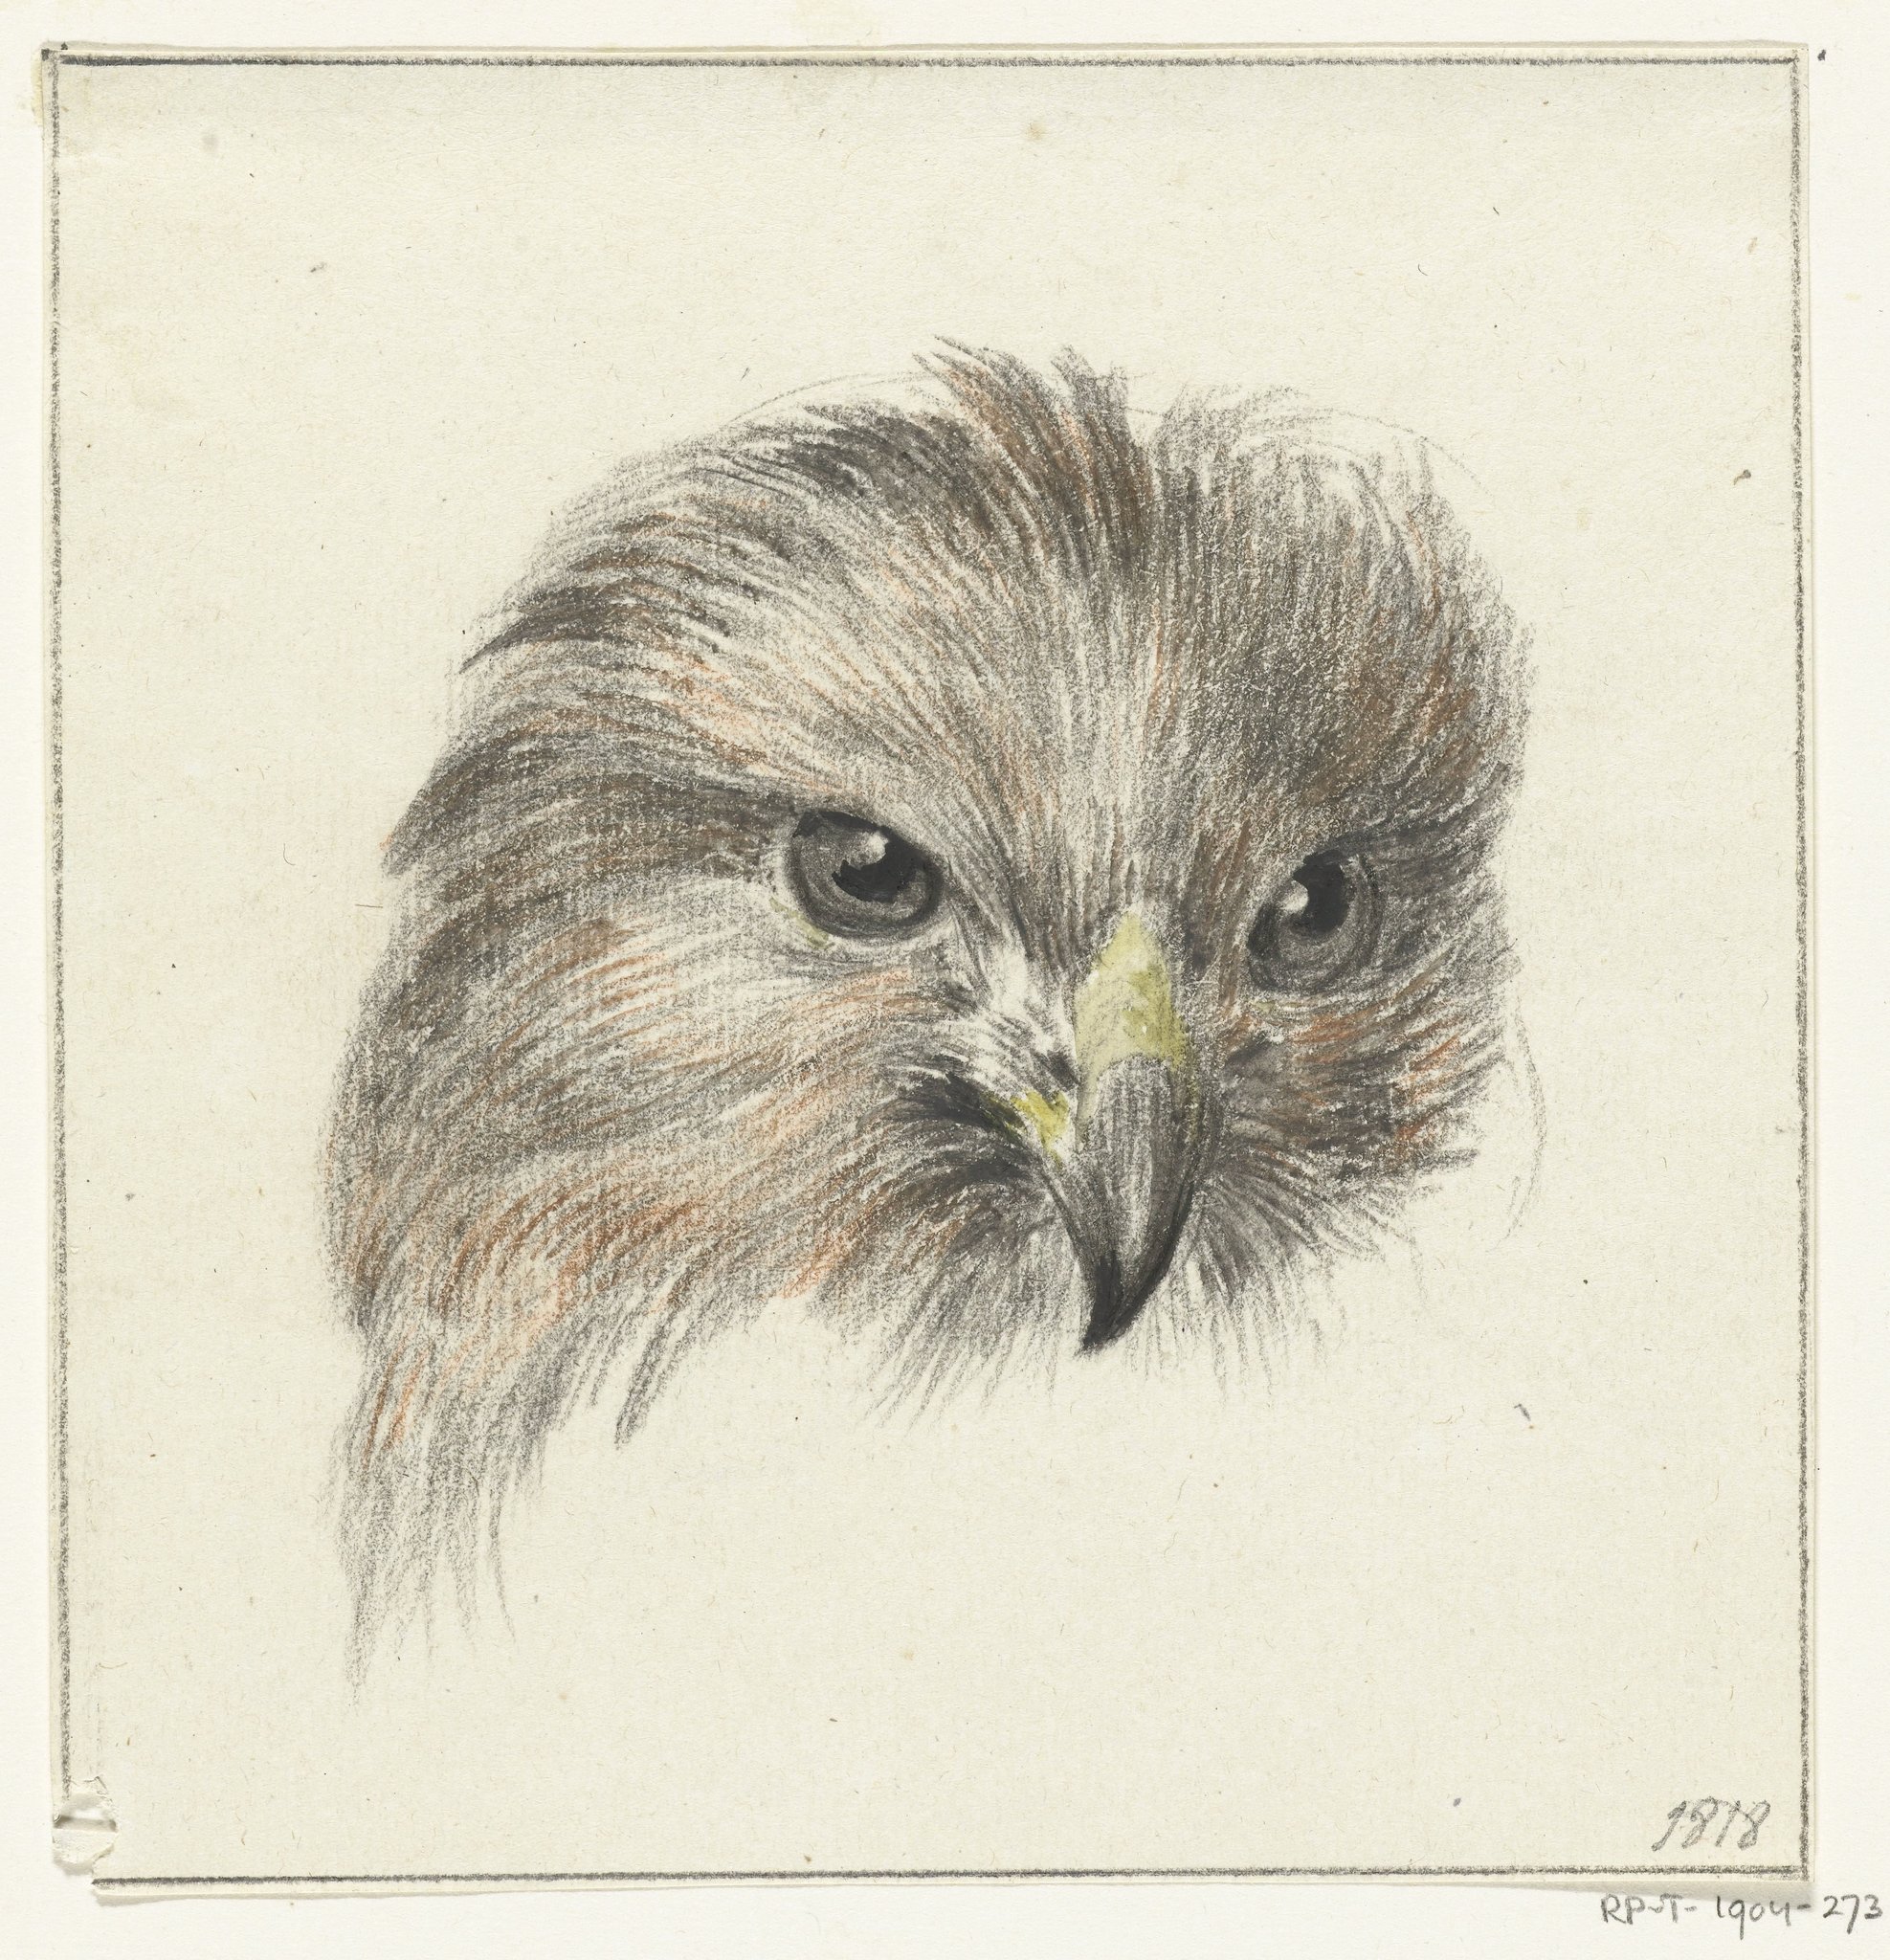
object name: drawing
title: Kop van een roofvogel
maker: jean bernard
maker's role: draughtsman, print maker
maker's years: 1765-1833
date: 1818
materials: chalk, paper, pencil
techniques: brush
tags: predatory birds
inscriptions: date: ‘1818’